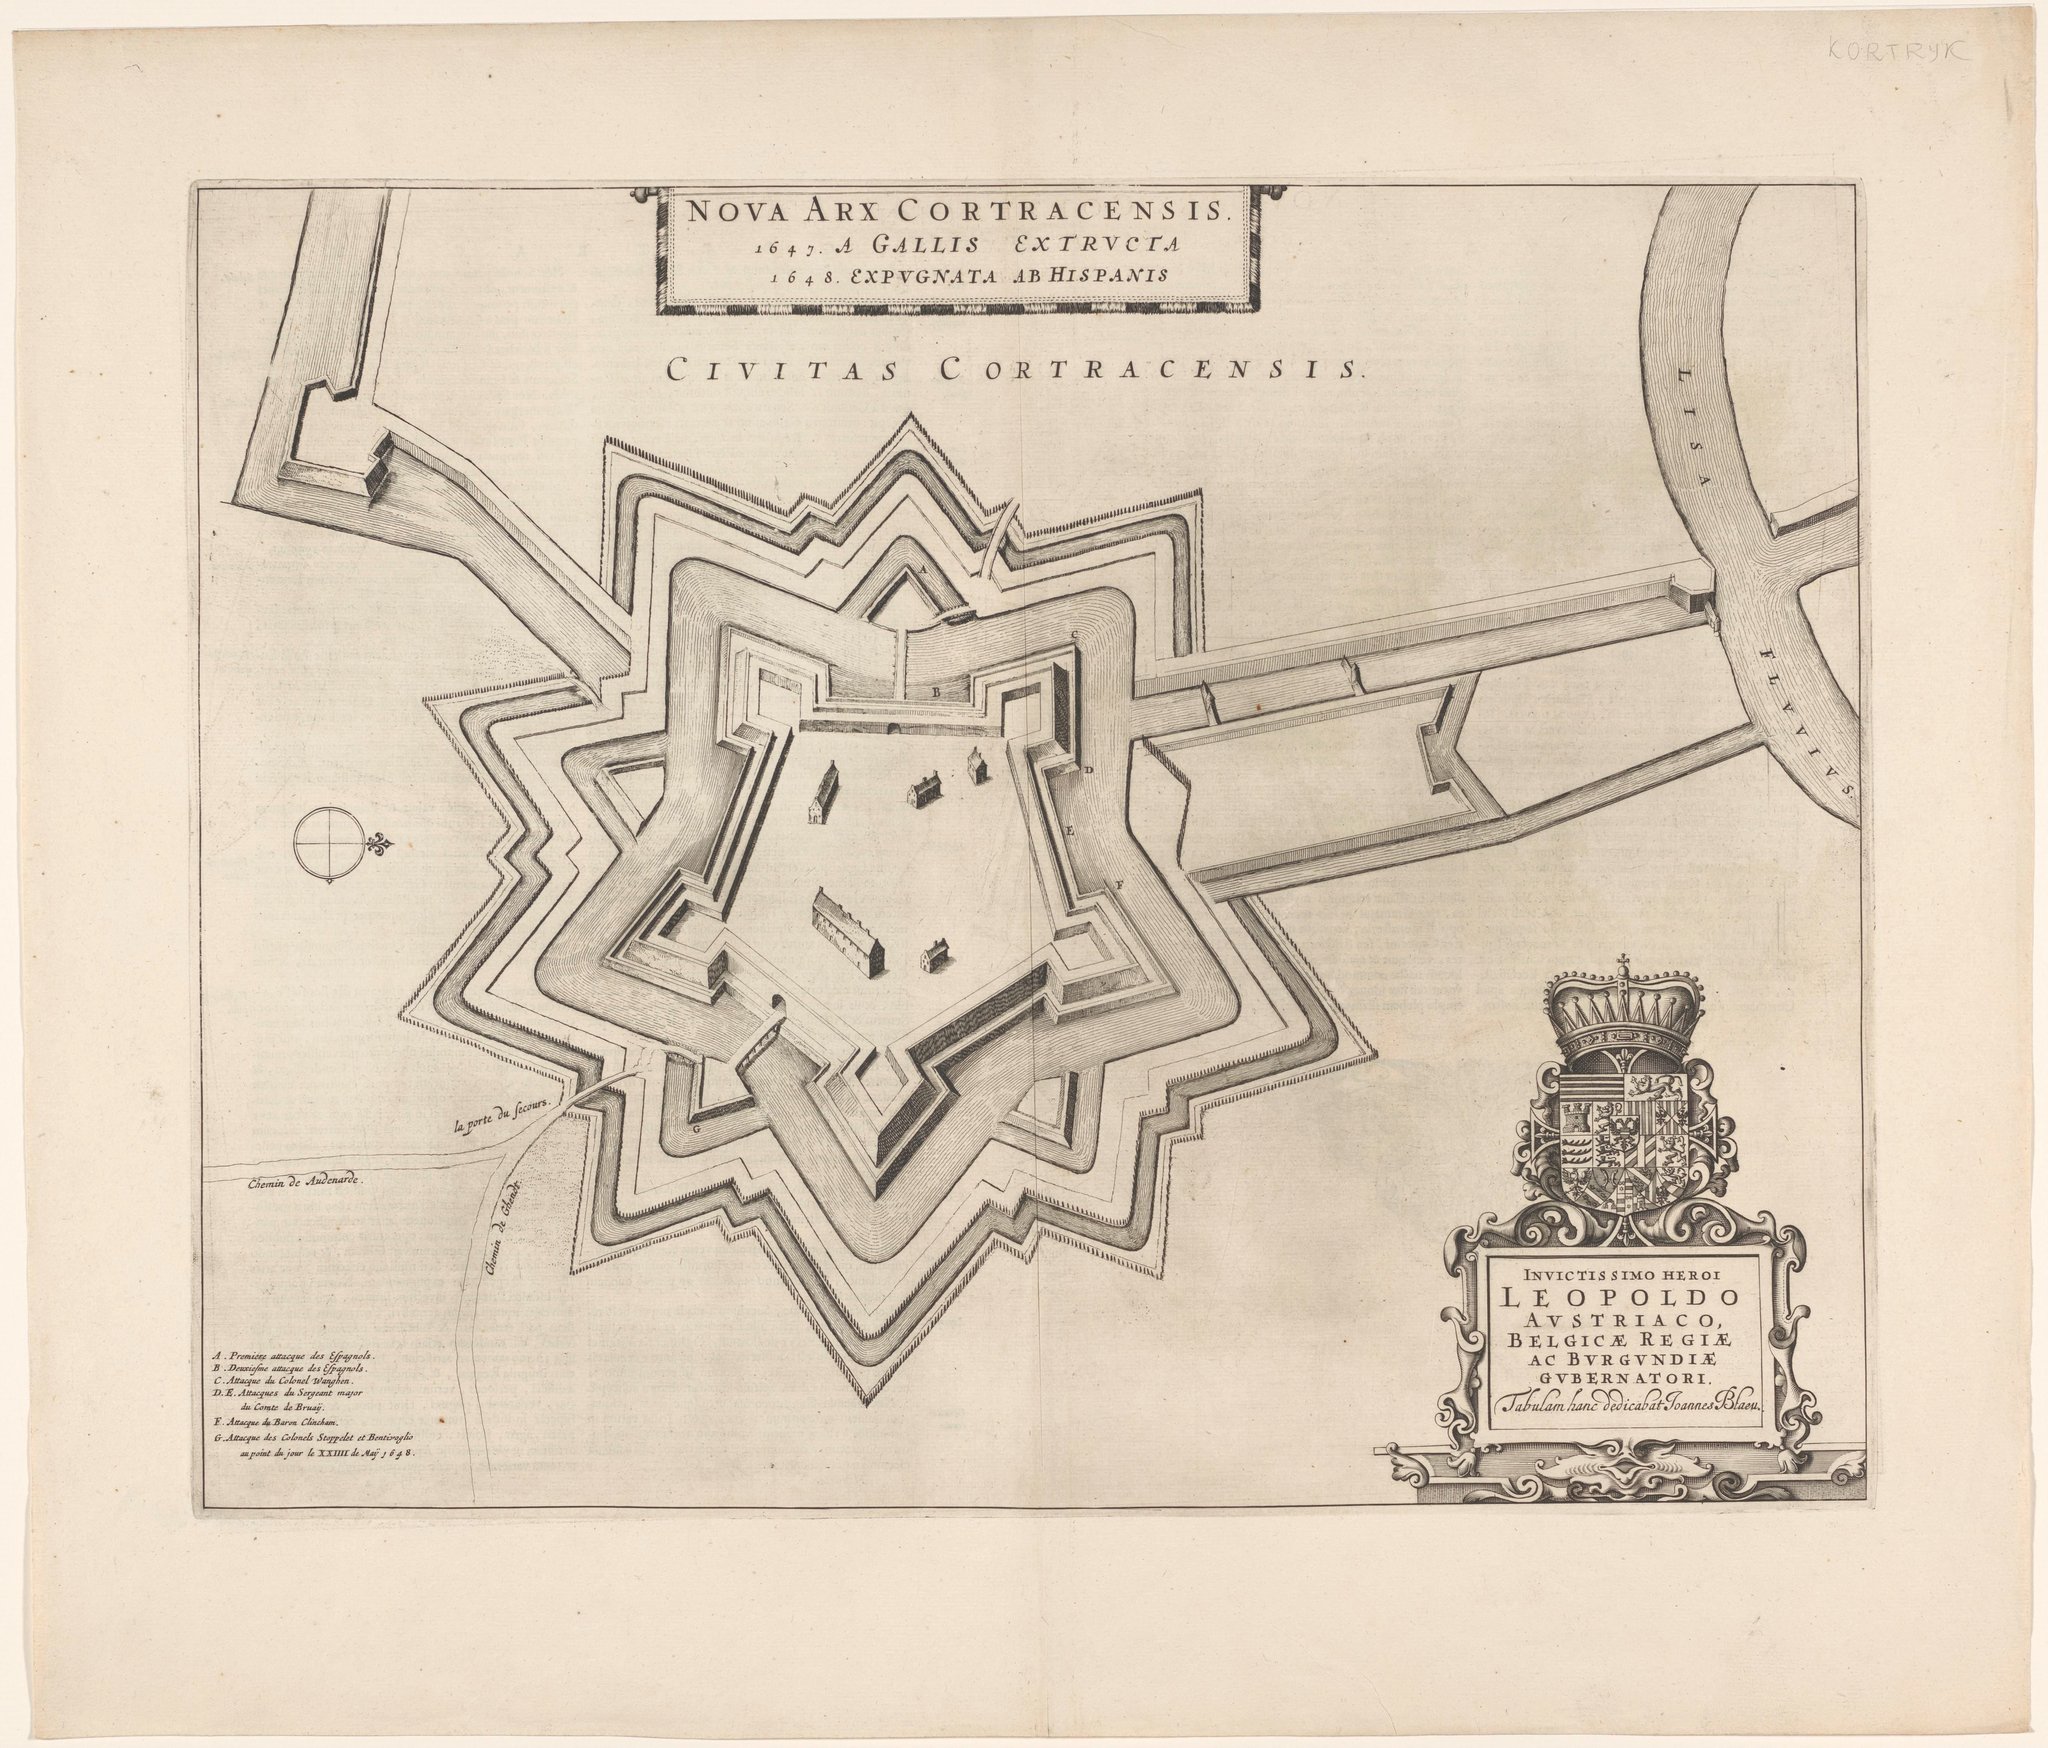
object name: print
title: Nova arx Cortracensis. 1647. a Gallis extructa 1648. expugnata ab Hispanis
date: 1652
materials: paper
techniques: engraving, etching, letterpress printing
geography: amsterdam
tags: fortified city, maps of cities, armorial bearing, heraldry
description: Prent gebruikt in: Blaeu, Johannes Willemszoon. Novum ac magnum theatrum urbium Belgicae (…). 2 delen. 3e druk. Amsterdam: Johannes Willemszoon Blaeu, 1652, dl. 2. Zie ook: Krogt, Peter van der. Nova Arx Cortracensis en aartshertog Leopold, de opdracht van Blaeus kaart van de Kortrijkse citadel. In: Caert-Thresoor, volume 30, 2011, p. 17-19.